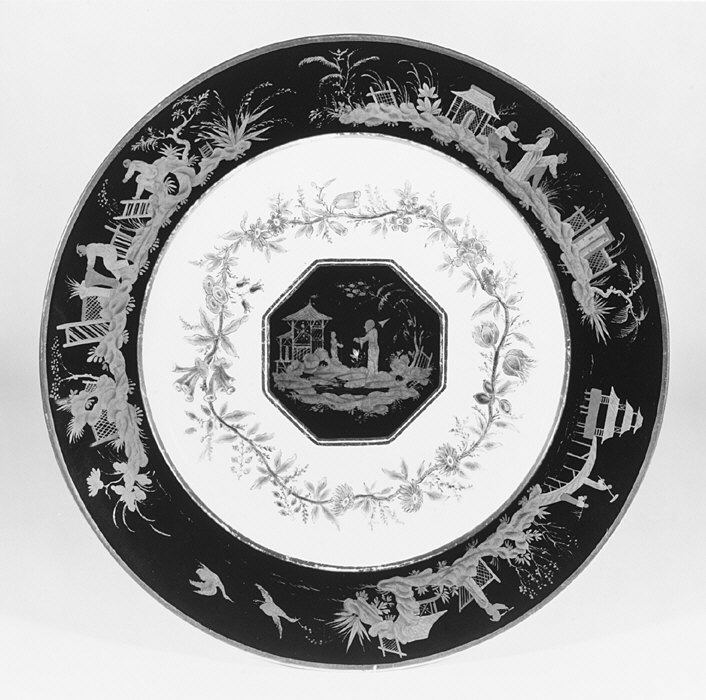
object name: plate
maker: sèvres manufactory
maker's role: manufactory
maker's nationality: french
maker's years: 1740-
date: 1791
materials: hard paste porcelain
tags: birds,chinoiserie,men,flowers